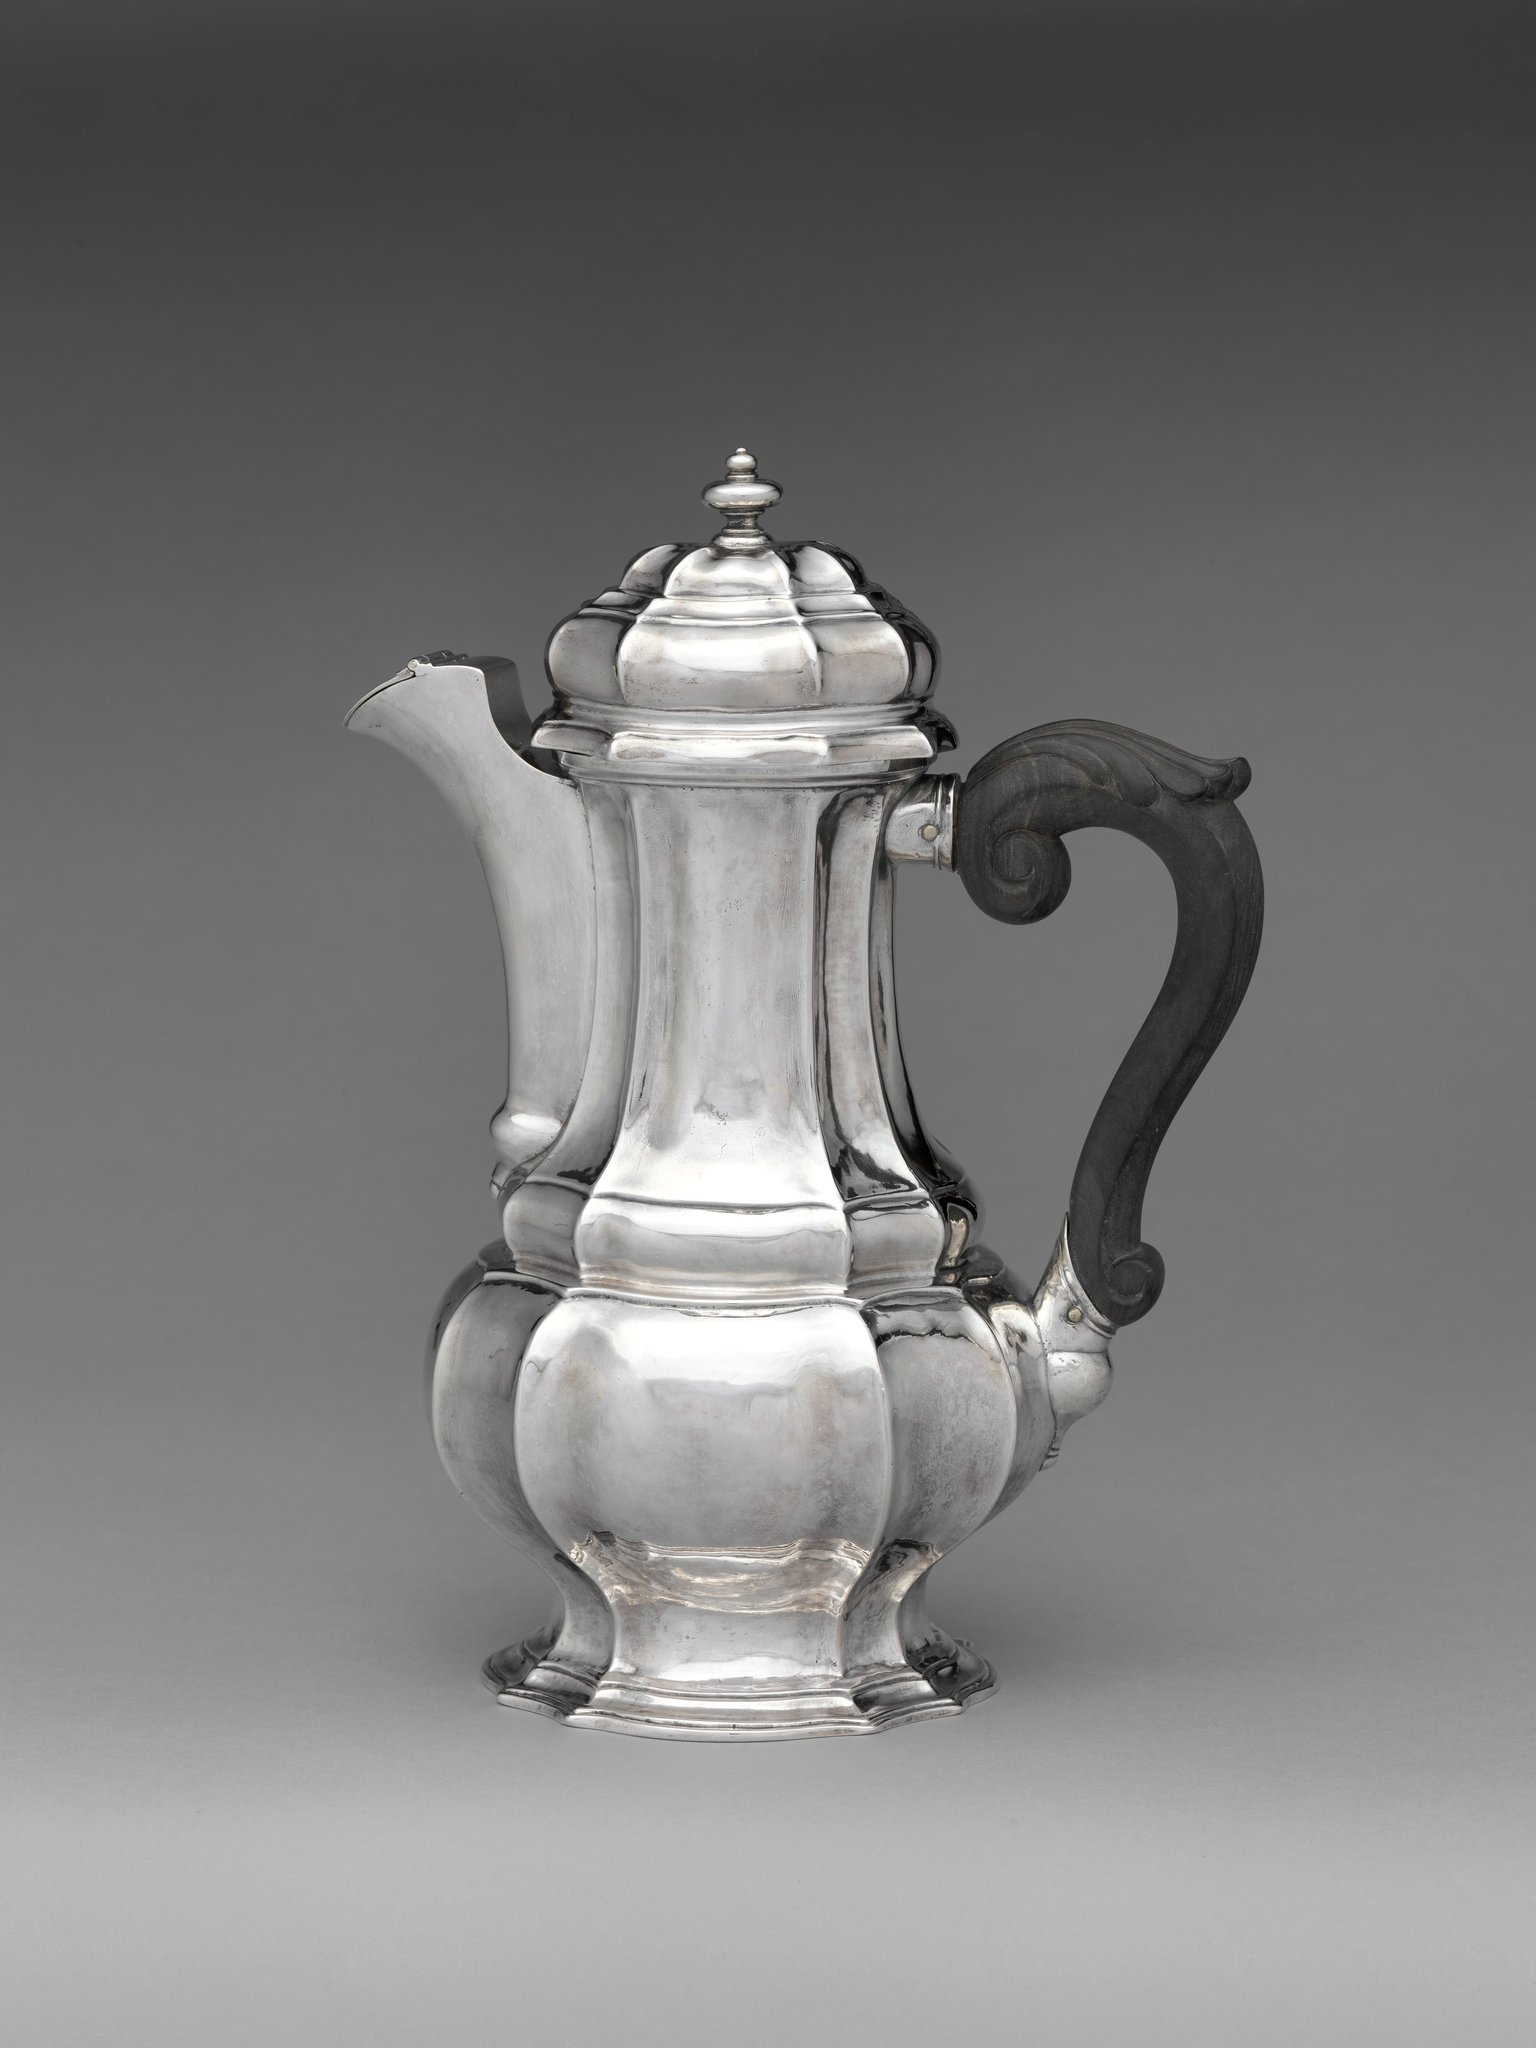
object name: coffeepot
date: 1740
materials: silver, wood